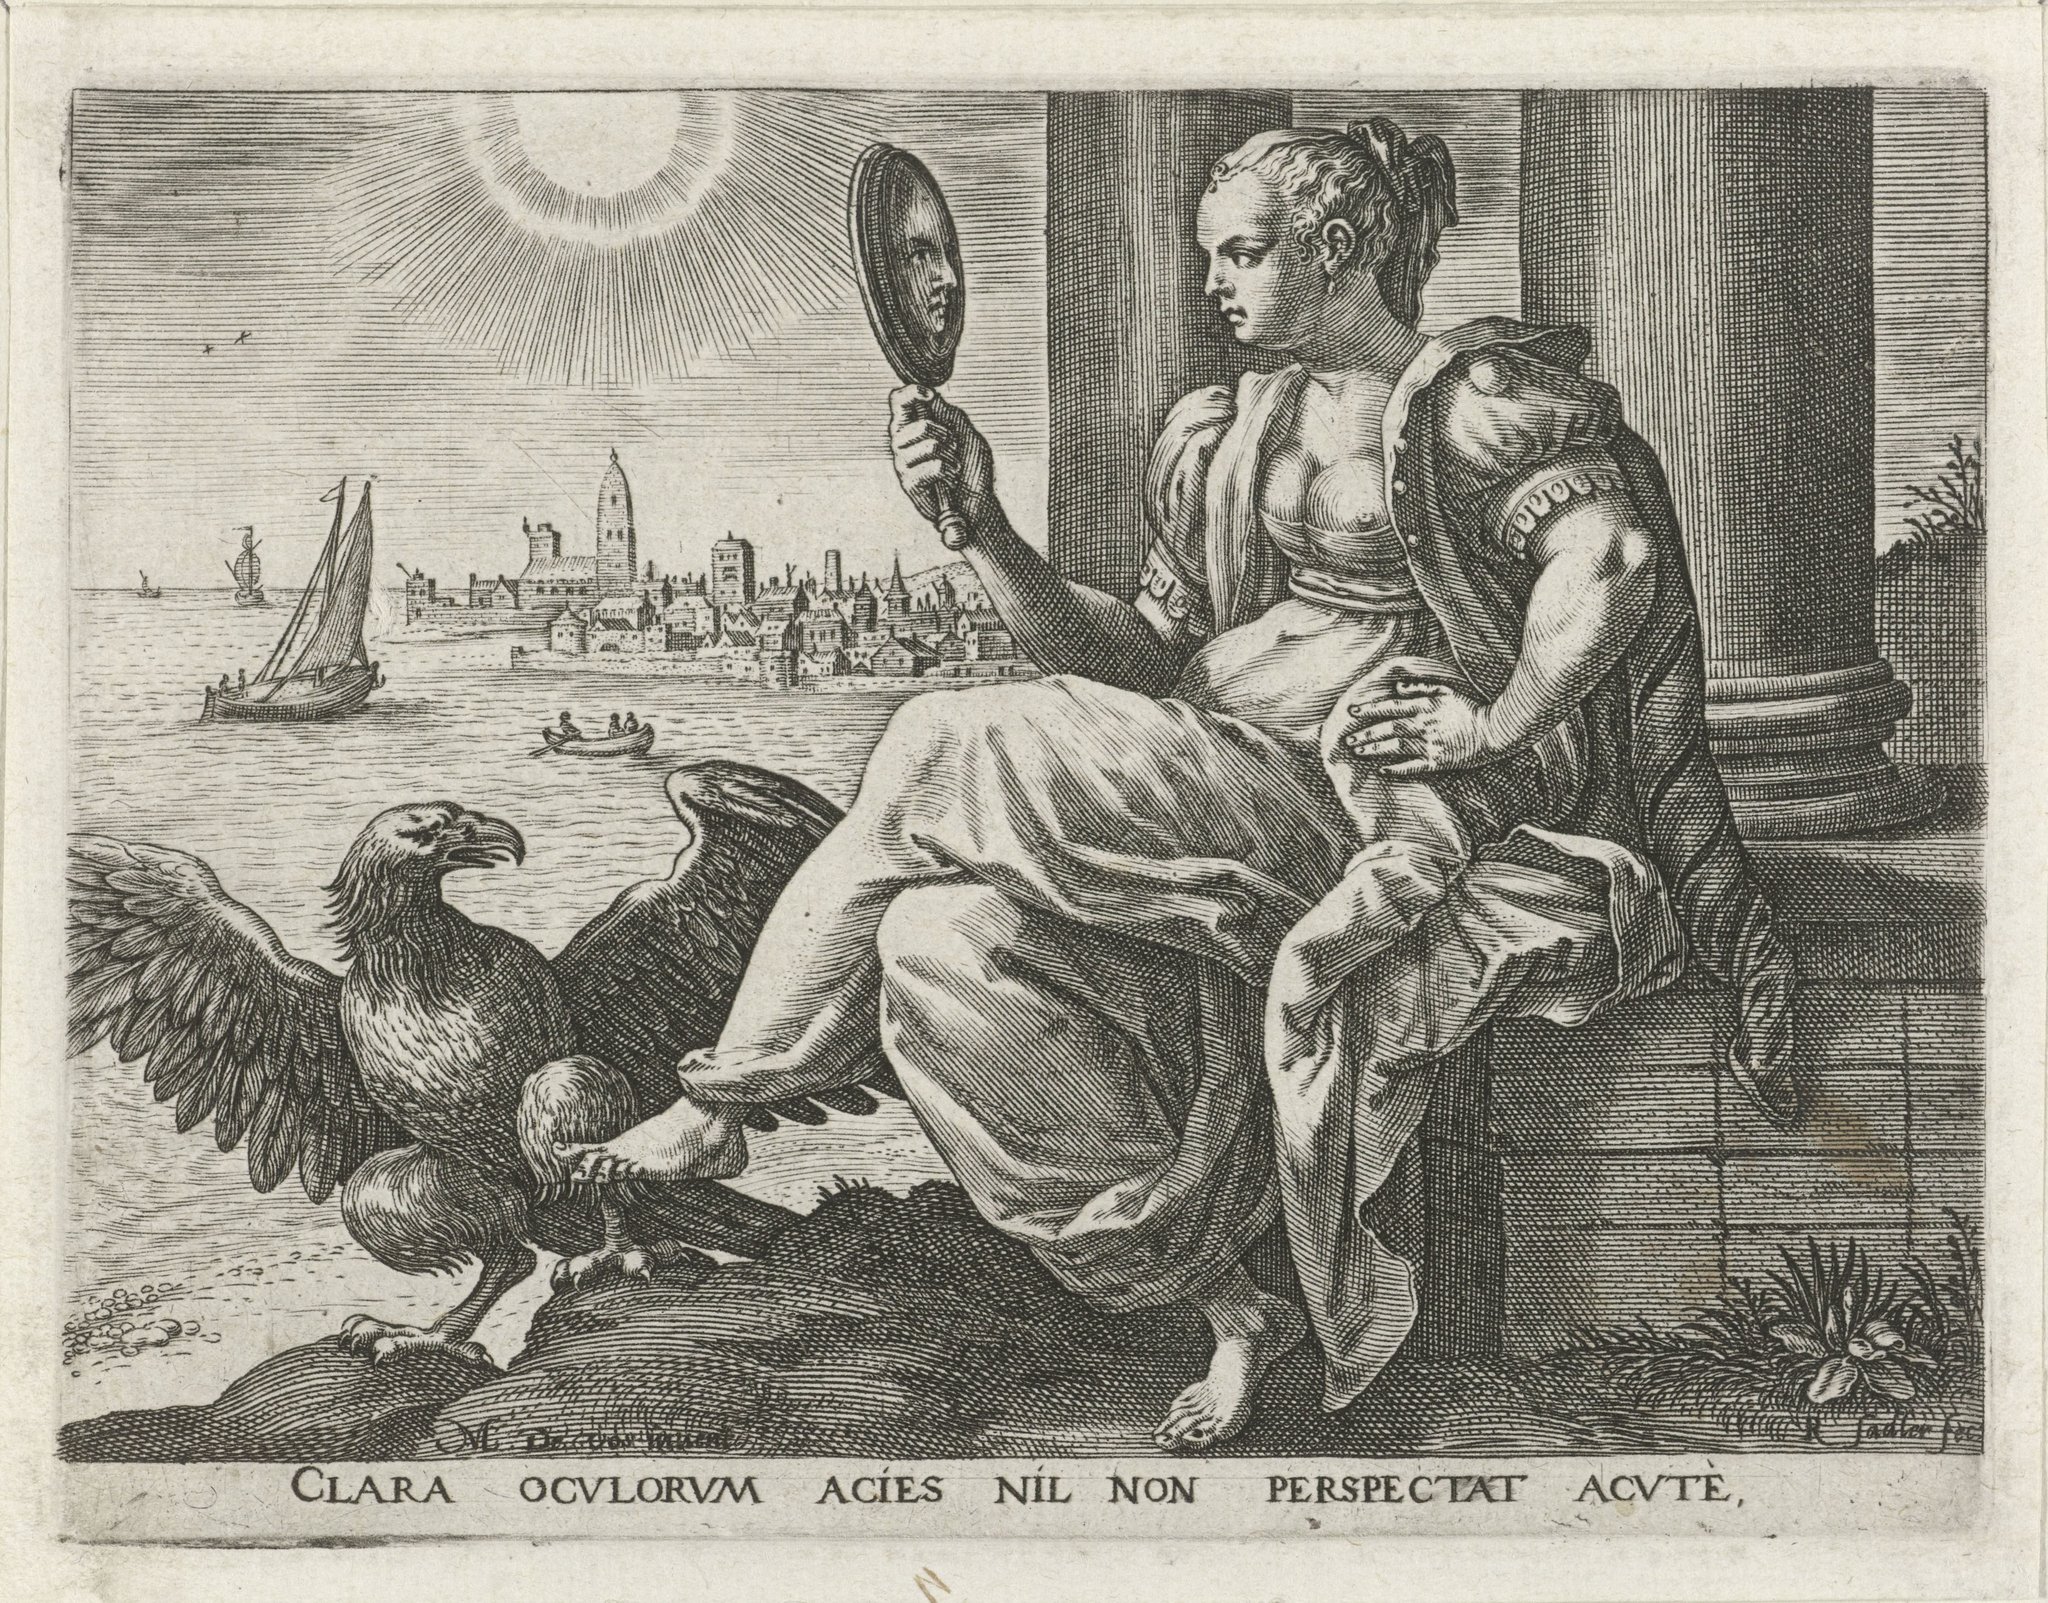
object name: print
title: De vijf zintuigen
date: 1581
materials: paper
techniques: engraving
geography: antwerp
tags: predatory birds: eagle, city-view in general; 'veduta', sight, looking (one of the five senses) - aa - female human figure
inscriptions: collector's mark: Lugt 240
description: De personificatie van het zicht. Ze kijkt in een handspiegel. Naast haar een adelaar. Op de achtergrond een kuststad. De prent heeft een Latijns onderschrift en is deel van een vijfdelige serie over de zintuigen.